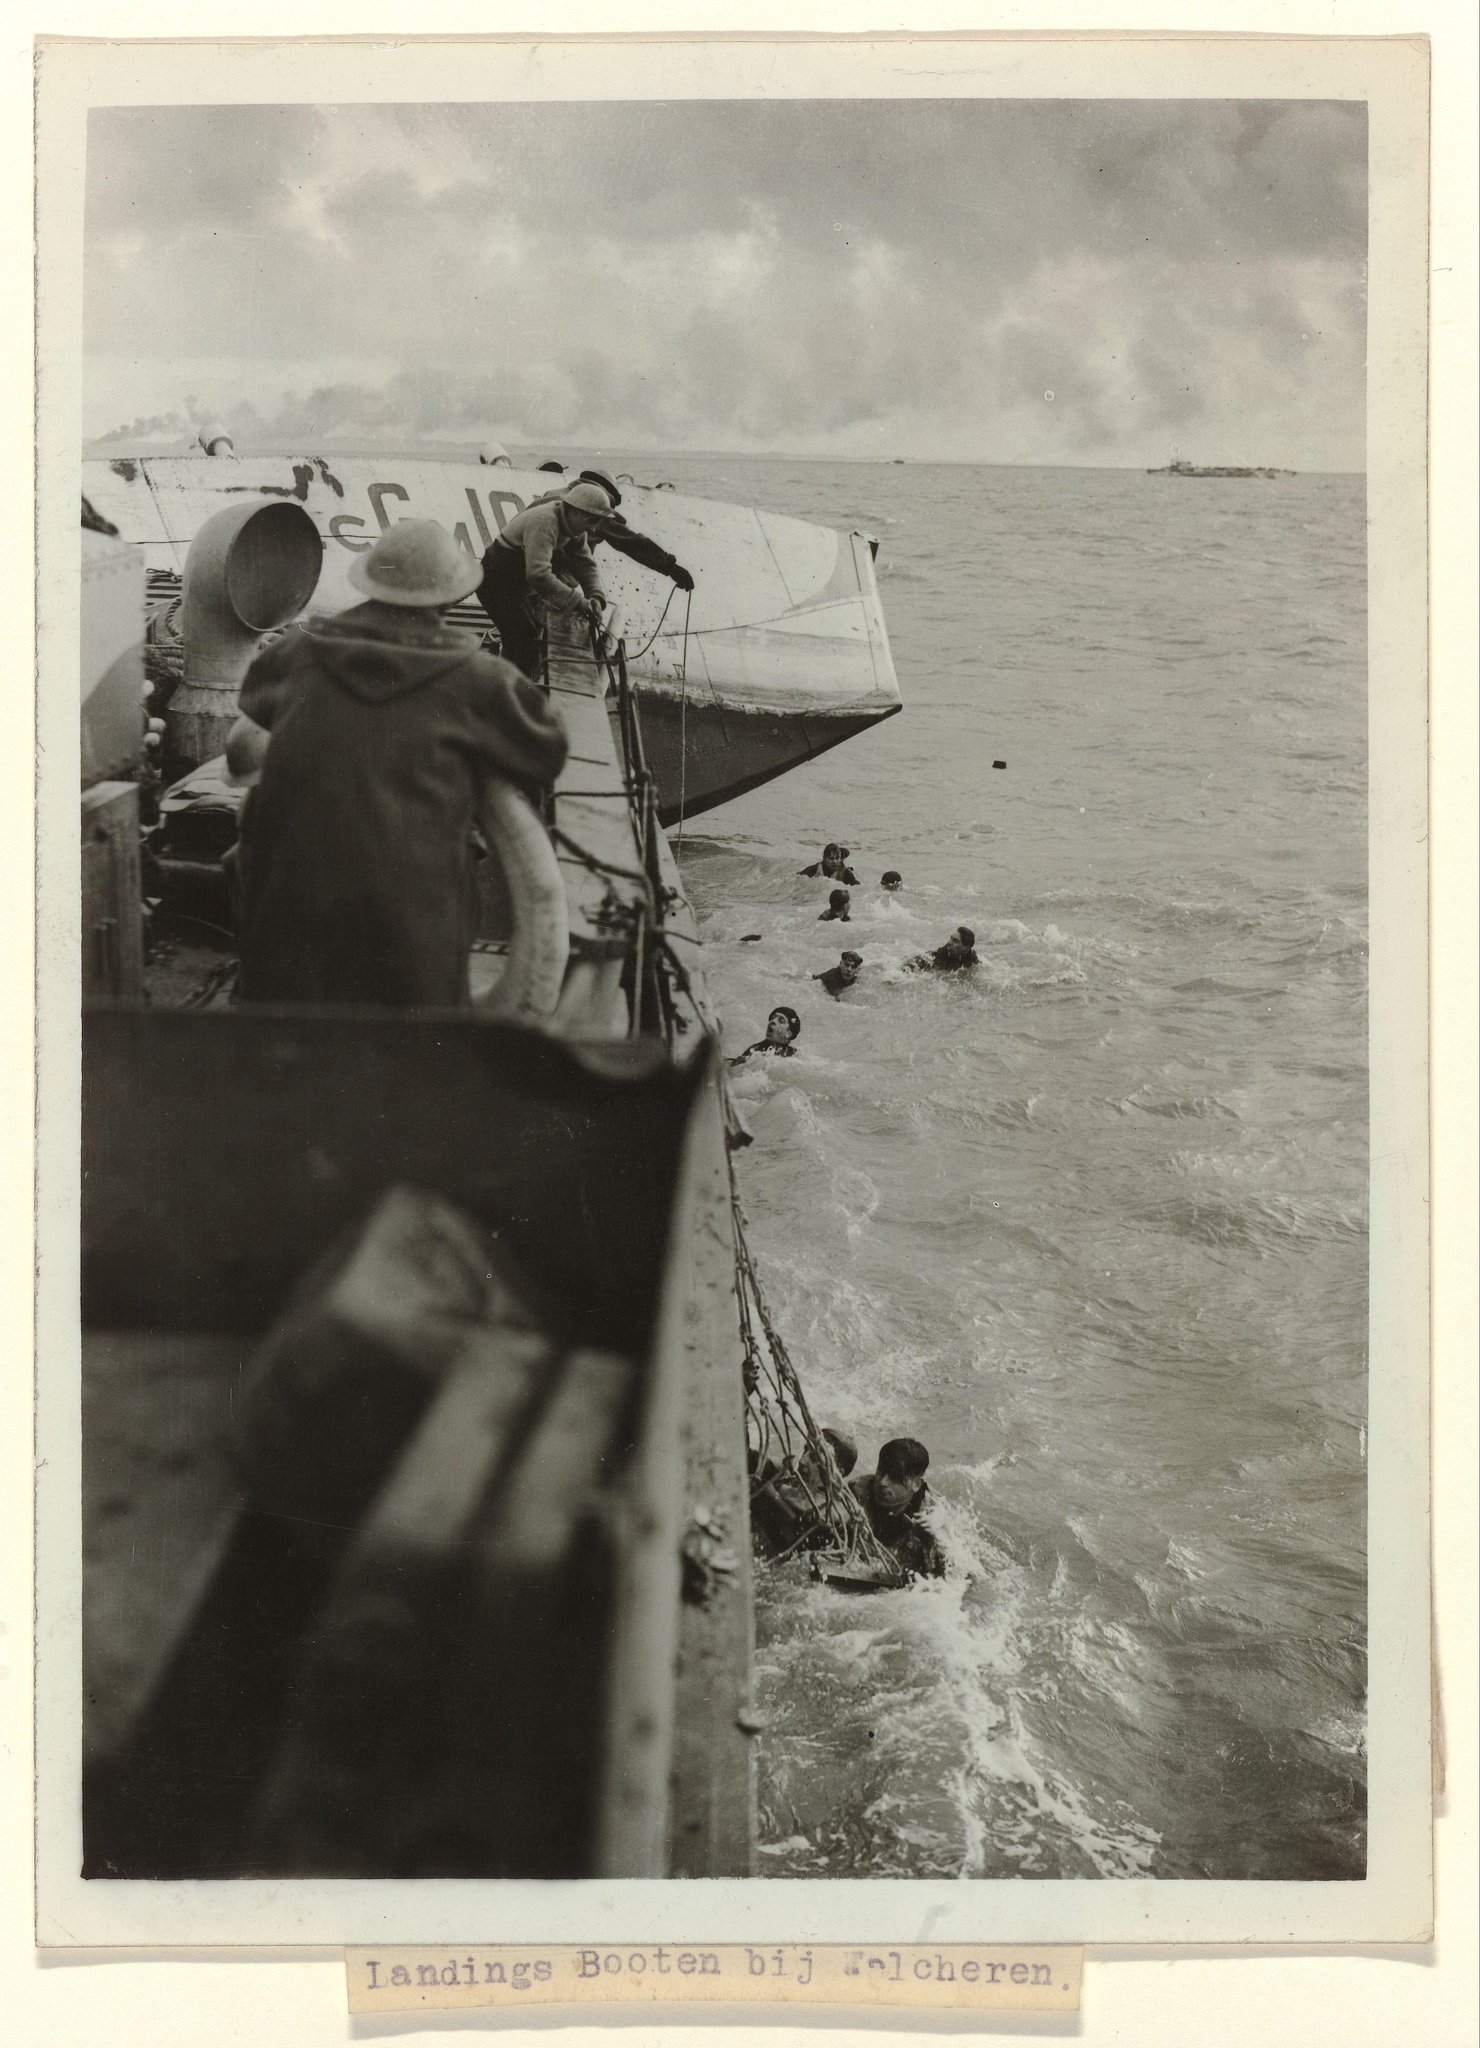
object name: documentary photograph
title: Engelse marine landt op Walcheren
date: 1911-1944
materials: photographic support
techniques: photography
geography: walcheren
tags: publisher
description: Overlevenden van een Brits marine vaartuig worden opgepikt door een landingsvaartuig dat dienst doet als hospitaal schip. Op de achtergrond is de rook te zien van de gevechten op het land.